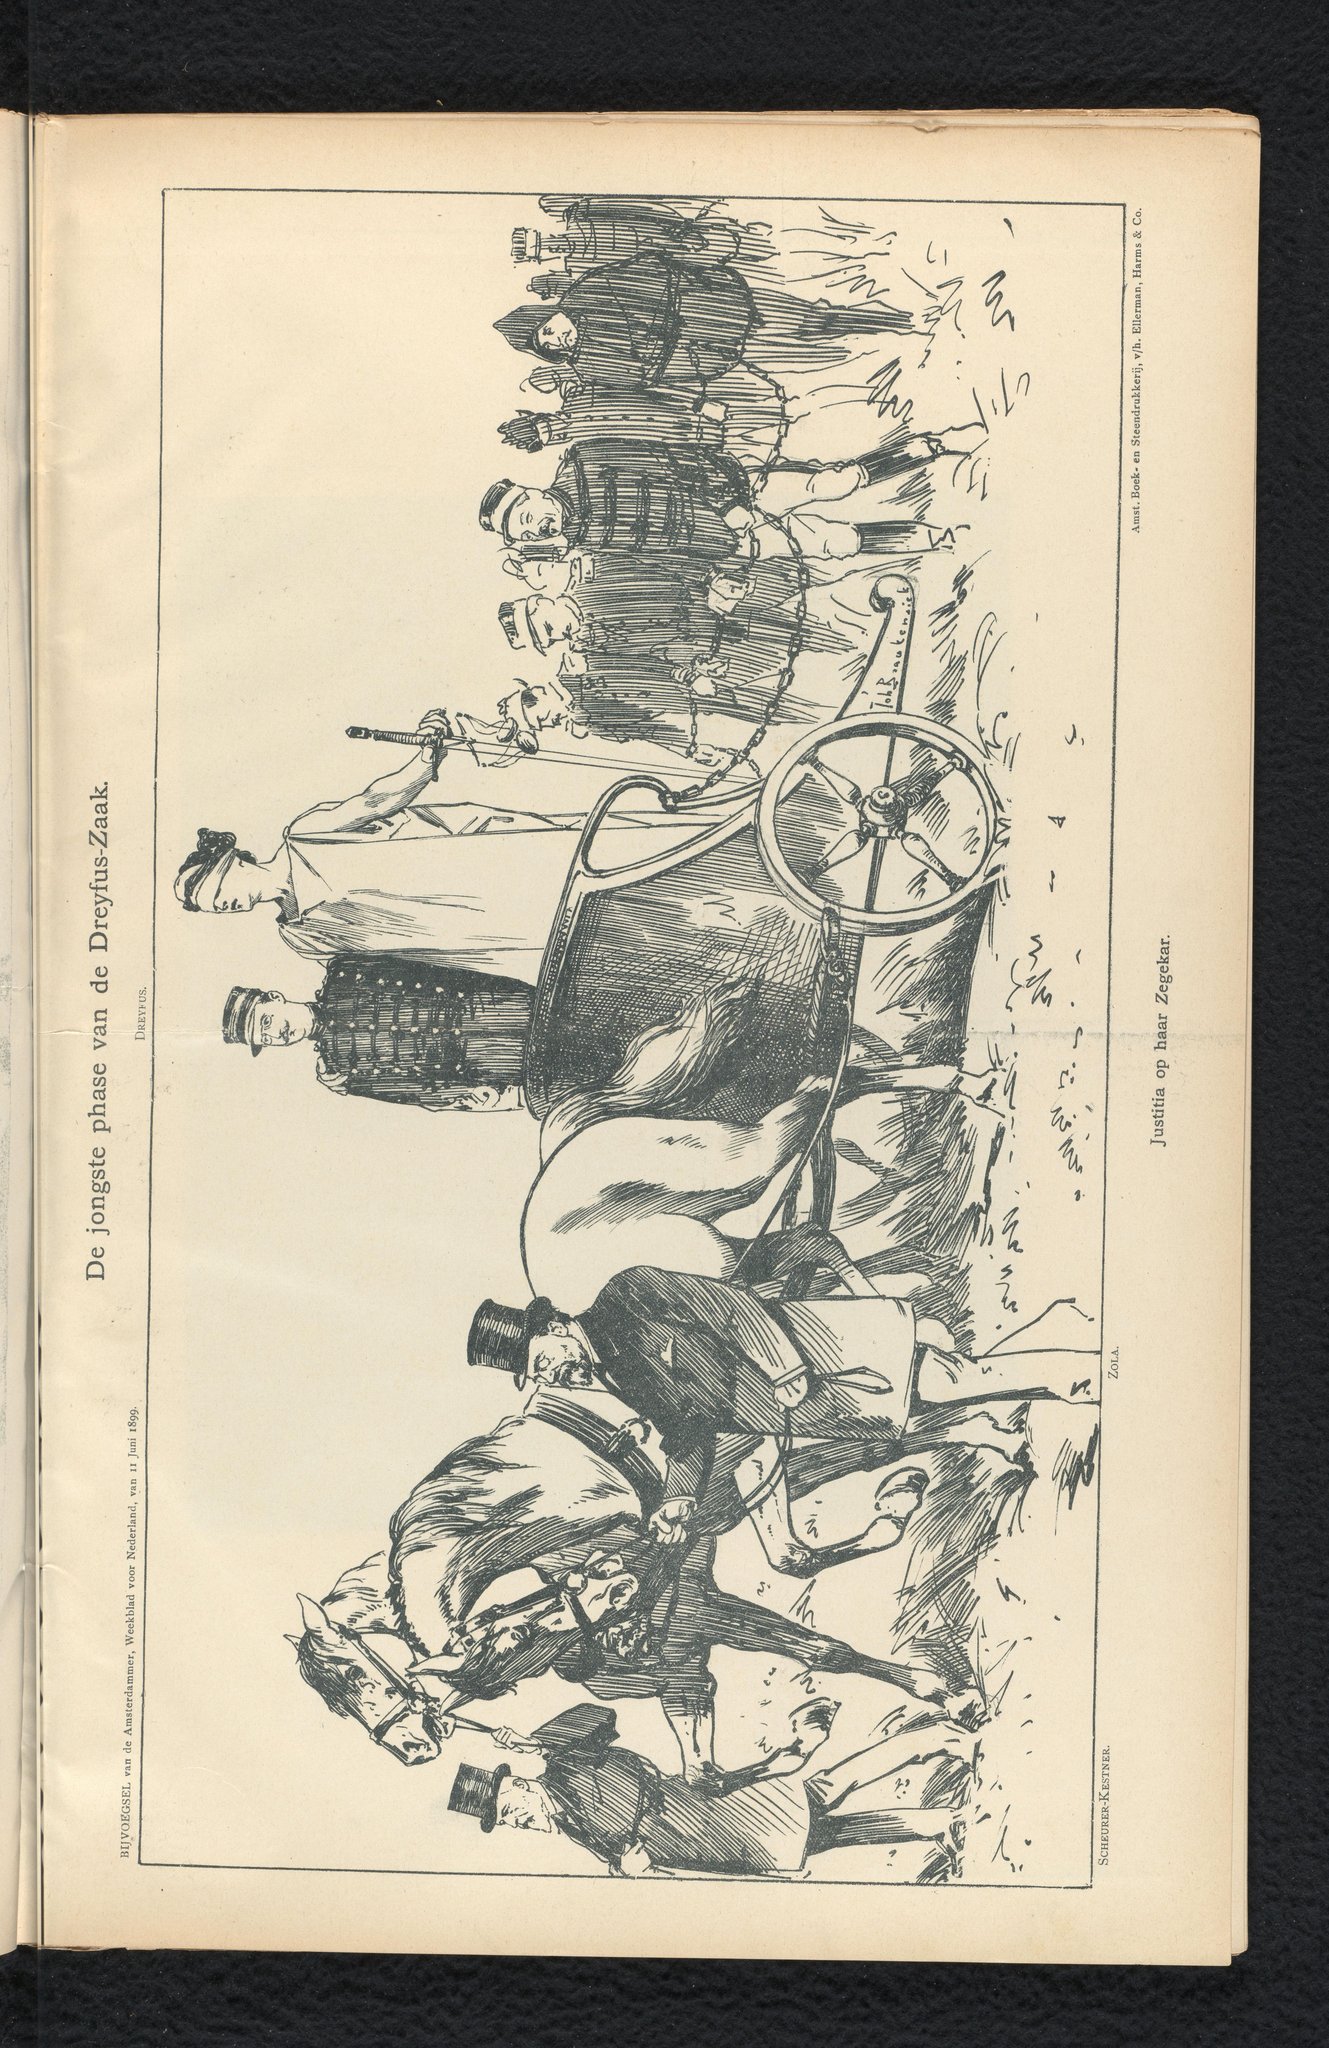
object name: cartoon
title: De jongste phase van de Dreyfus-Zaak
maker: johan braakensiek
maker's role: draughtsman, print maker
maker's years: 1858-1940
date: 1899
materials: paper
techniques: lithograph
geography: netherlands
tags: emile zola, paris, prisoners chained to the victor's chariot, justice, 'justitia'; 'giustitia divina' (ripa) ~ one of the four cardinal virtues, political caricatures and satires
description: Vrouwe Justitia met Dreyfus rijdend in een triomfwagen, de paarden geleid door Zola en Scheurer-Kestner. Achter de wagen worden als geboeide gevangenen Franse militairen meegevoerd.